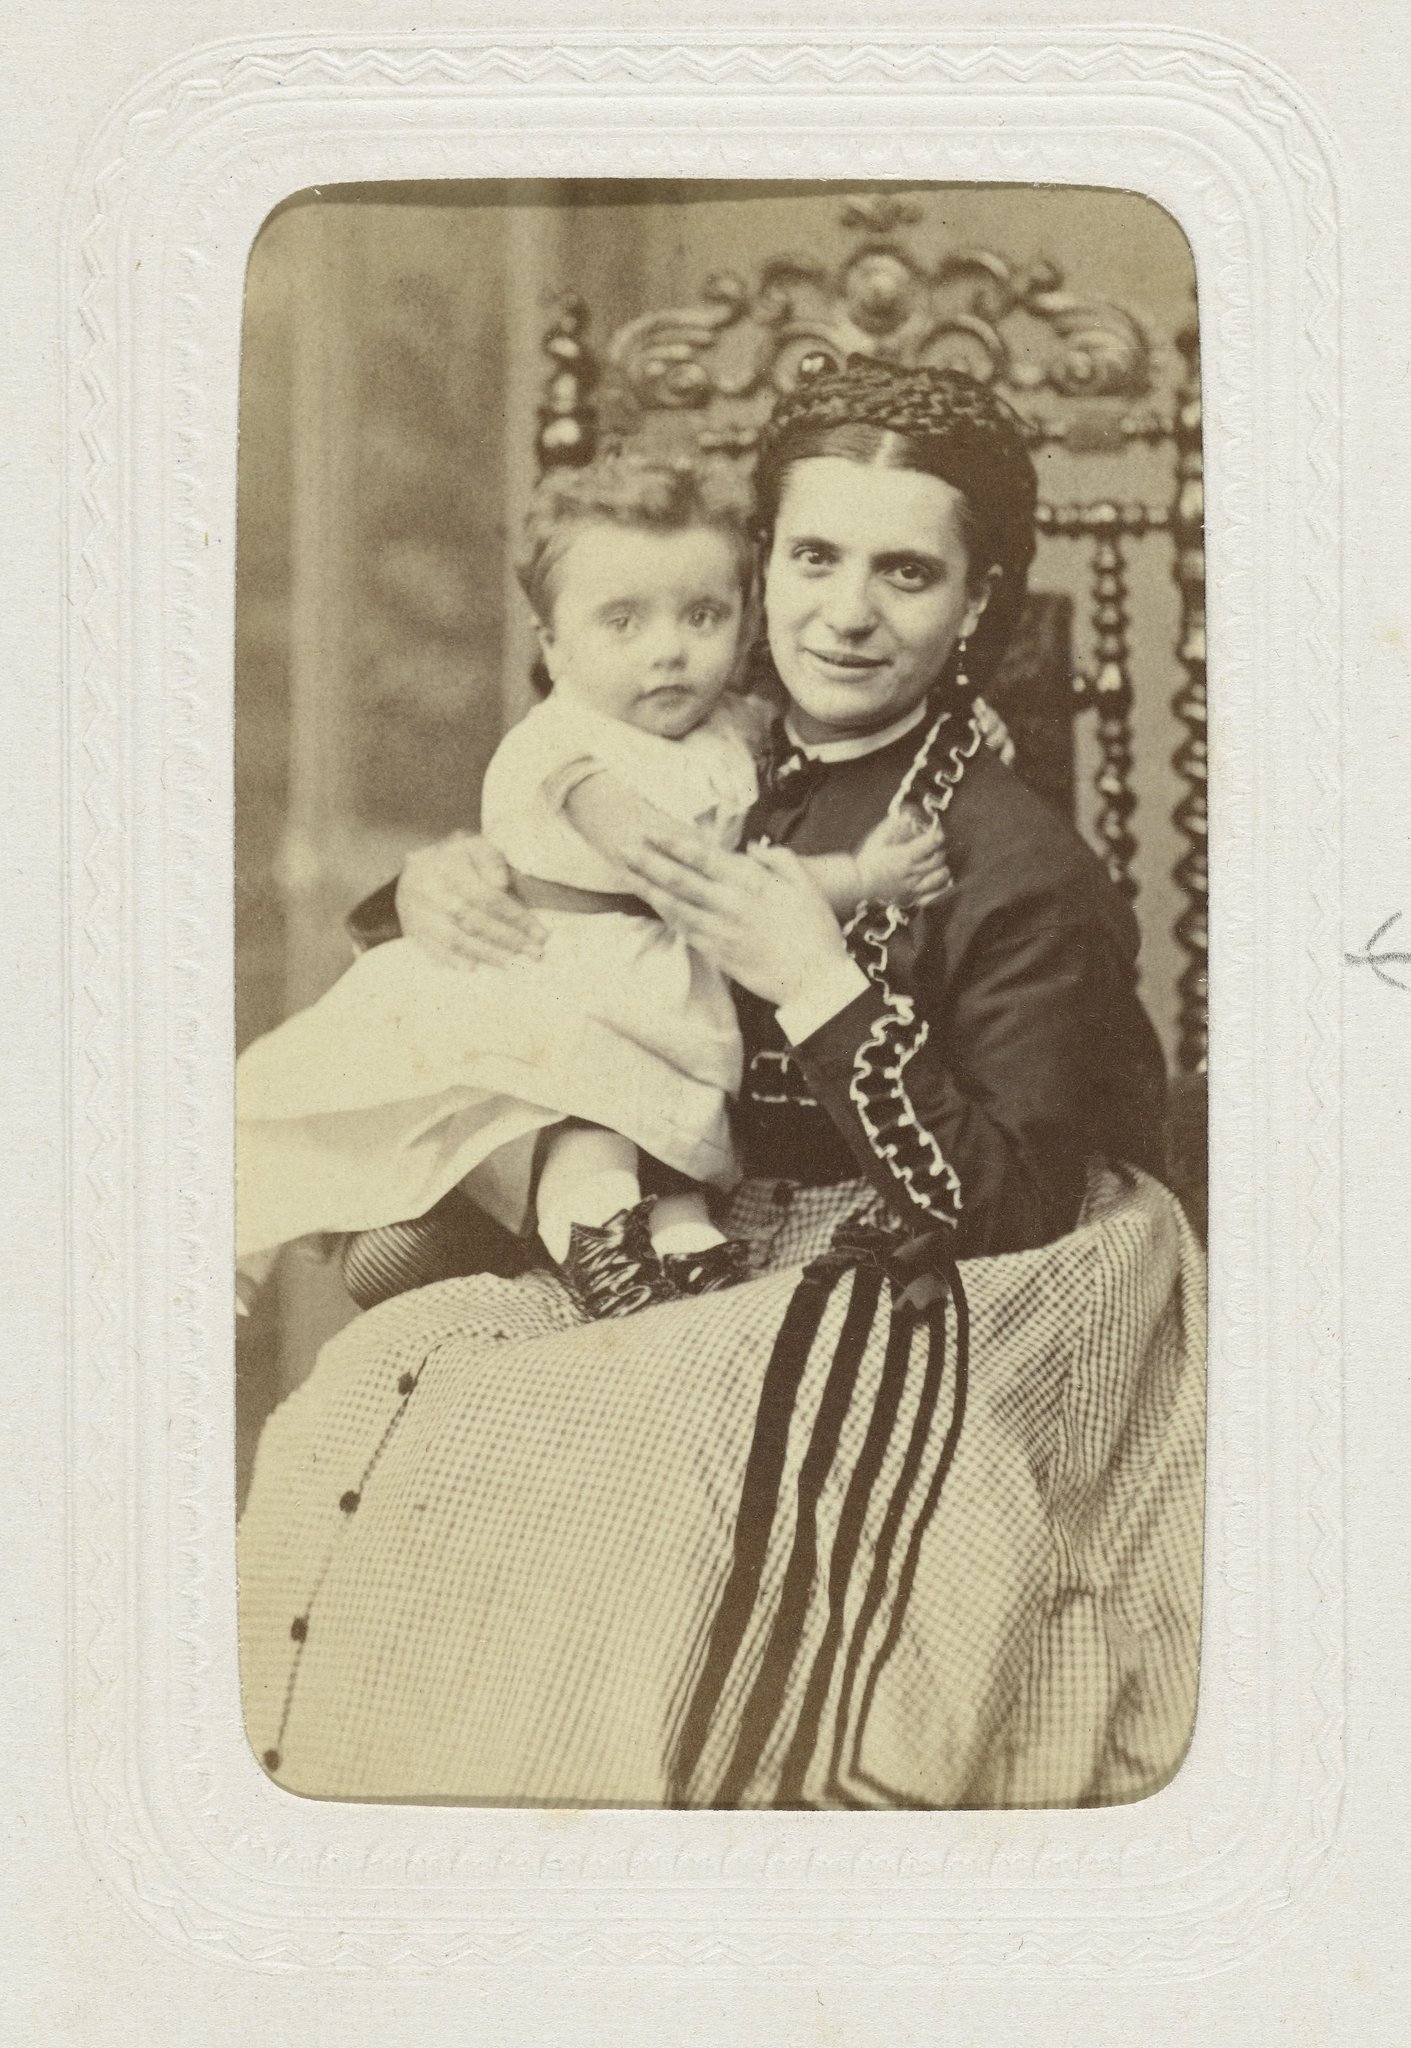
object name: carte de visite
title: Studioportret van een vrouw met kind op schoot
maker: franz wilhelm deutmann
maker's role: fotograaf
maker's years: 1809-1895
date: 1863-1866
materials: cardboard, paper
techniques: albumen print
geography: amsterdam